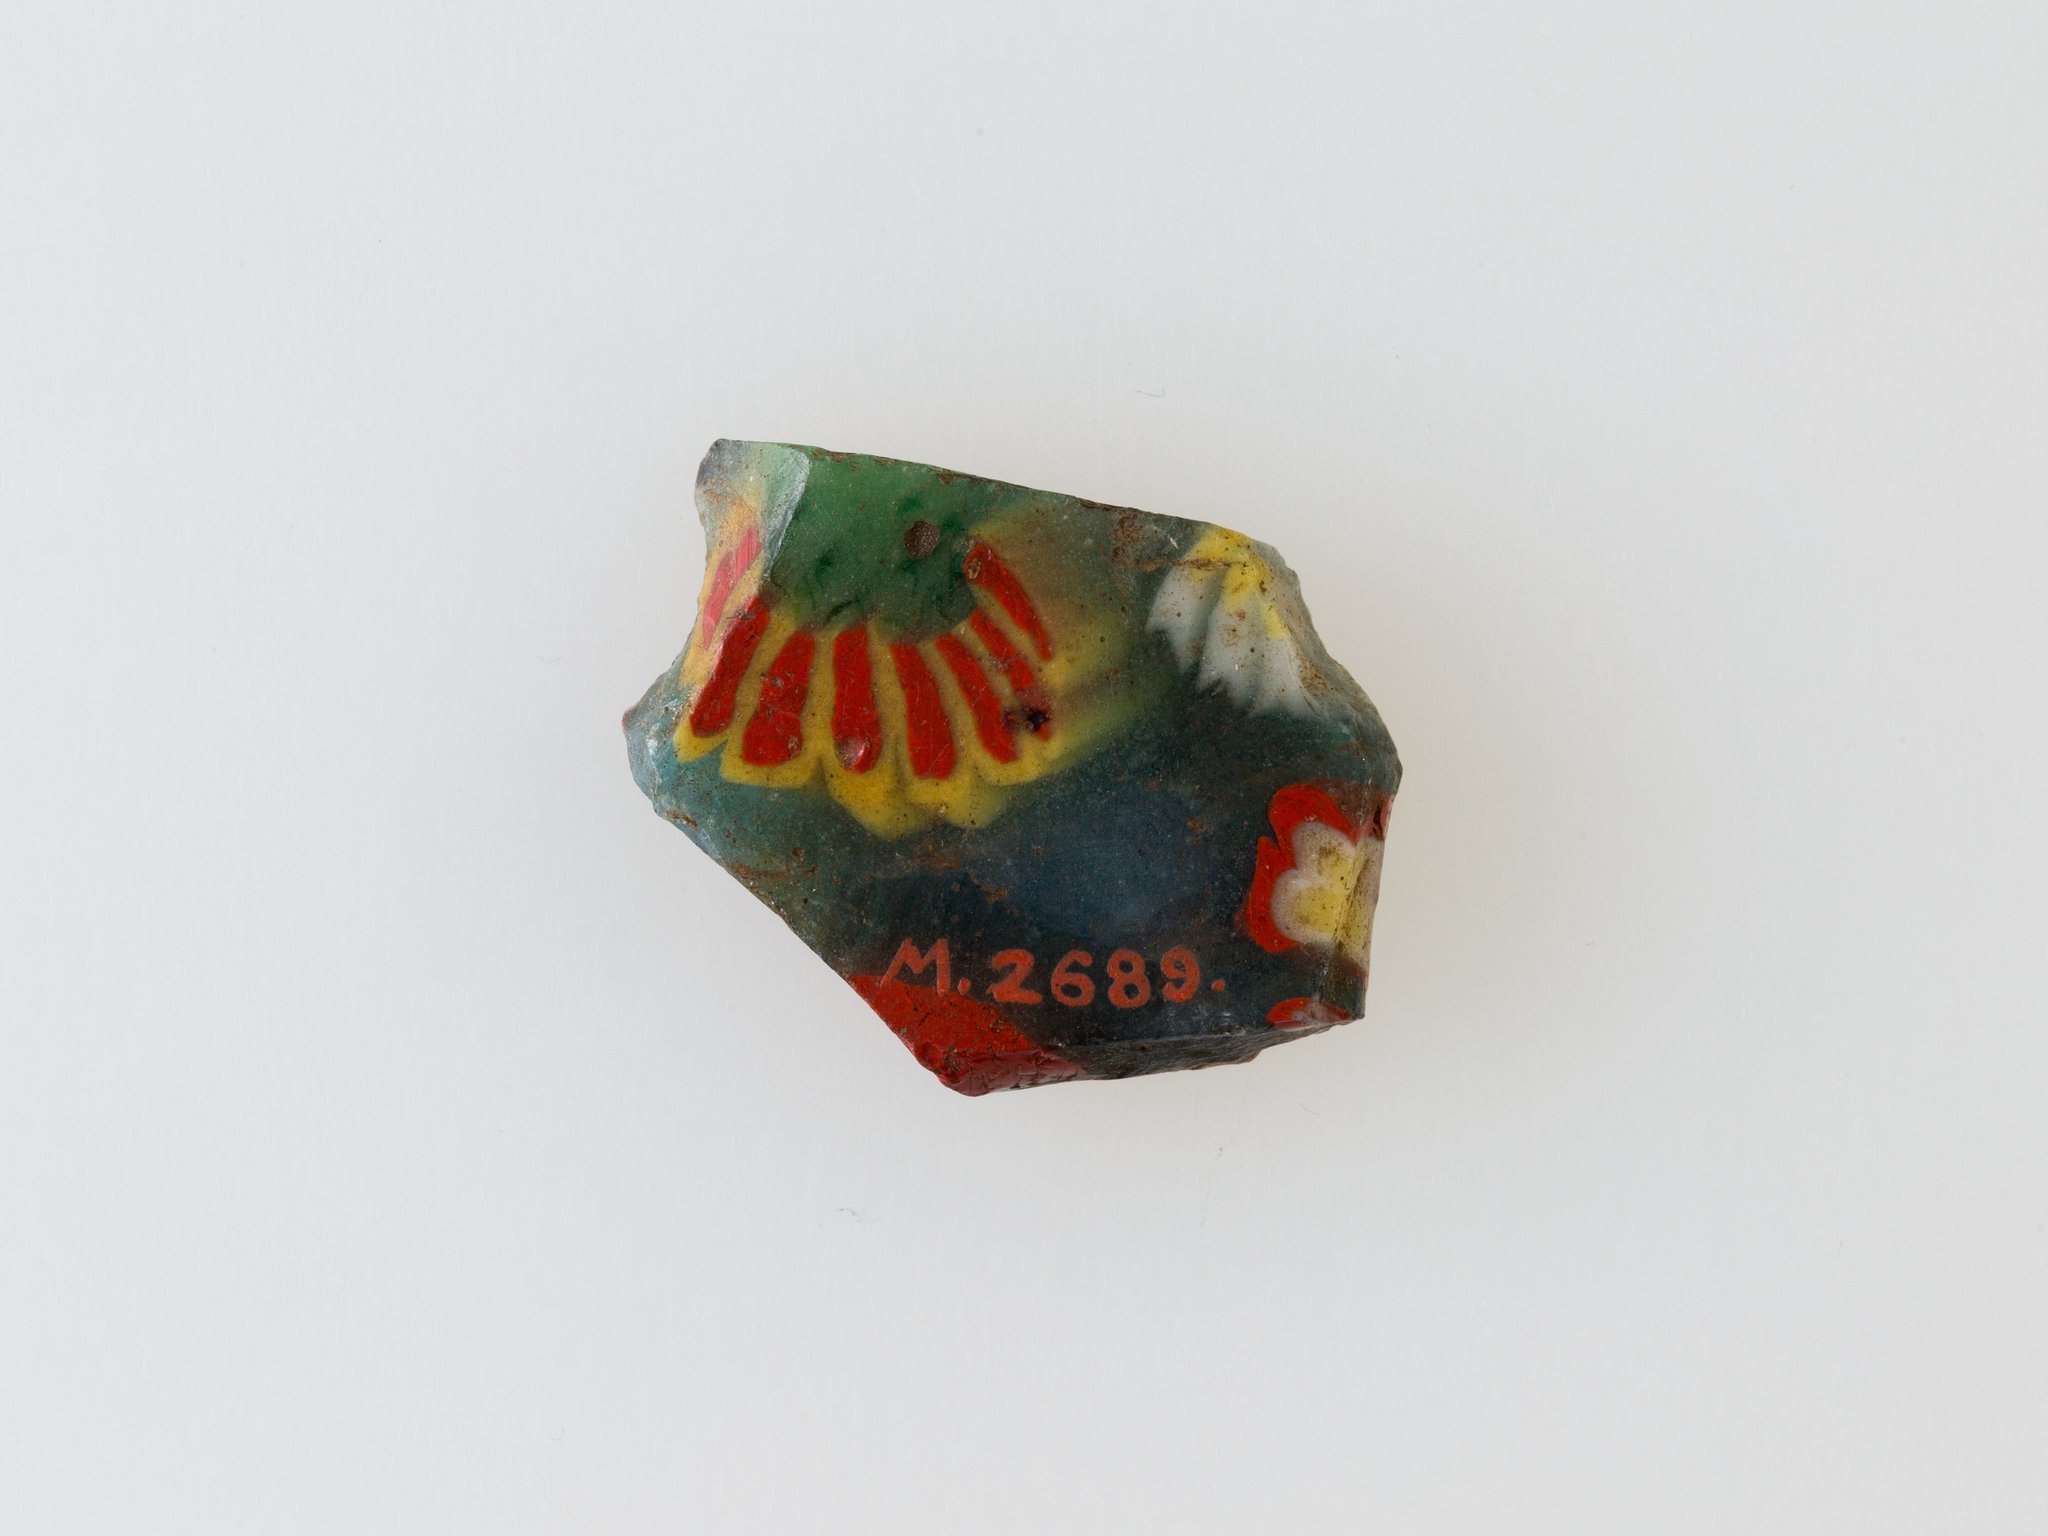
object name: plaque, floral, inlay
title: Floral plaque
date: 100 BCE-100 CE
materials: glass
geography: egypt